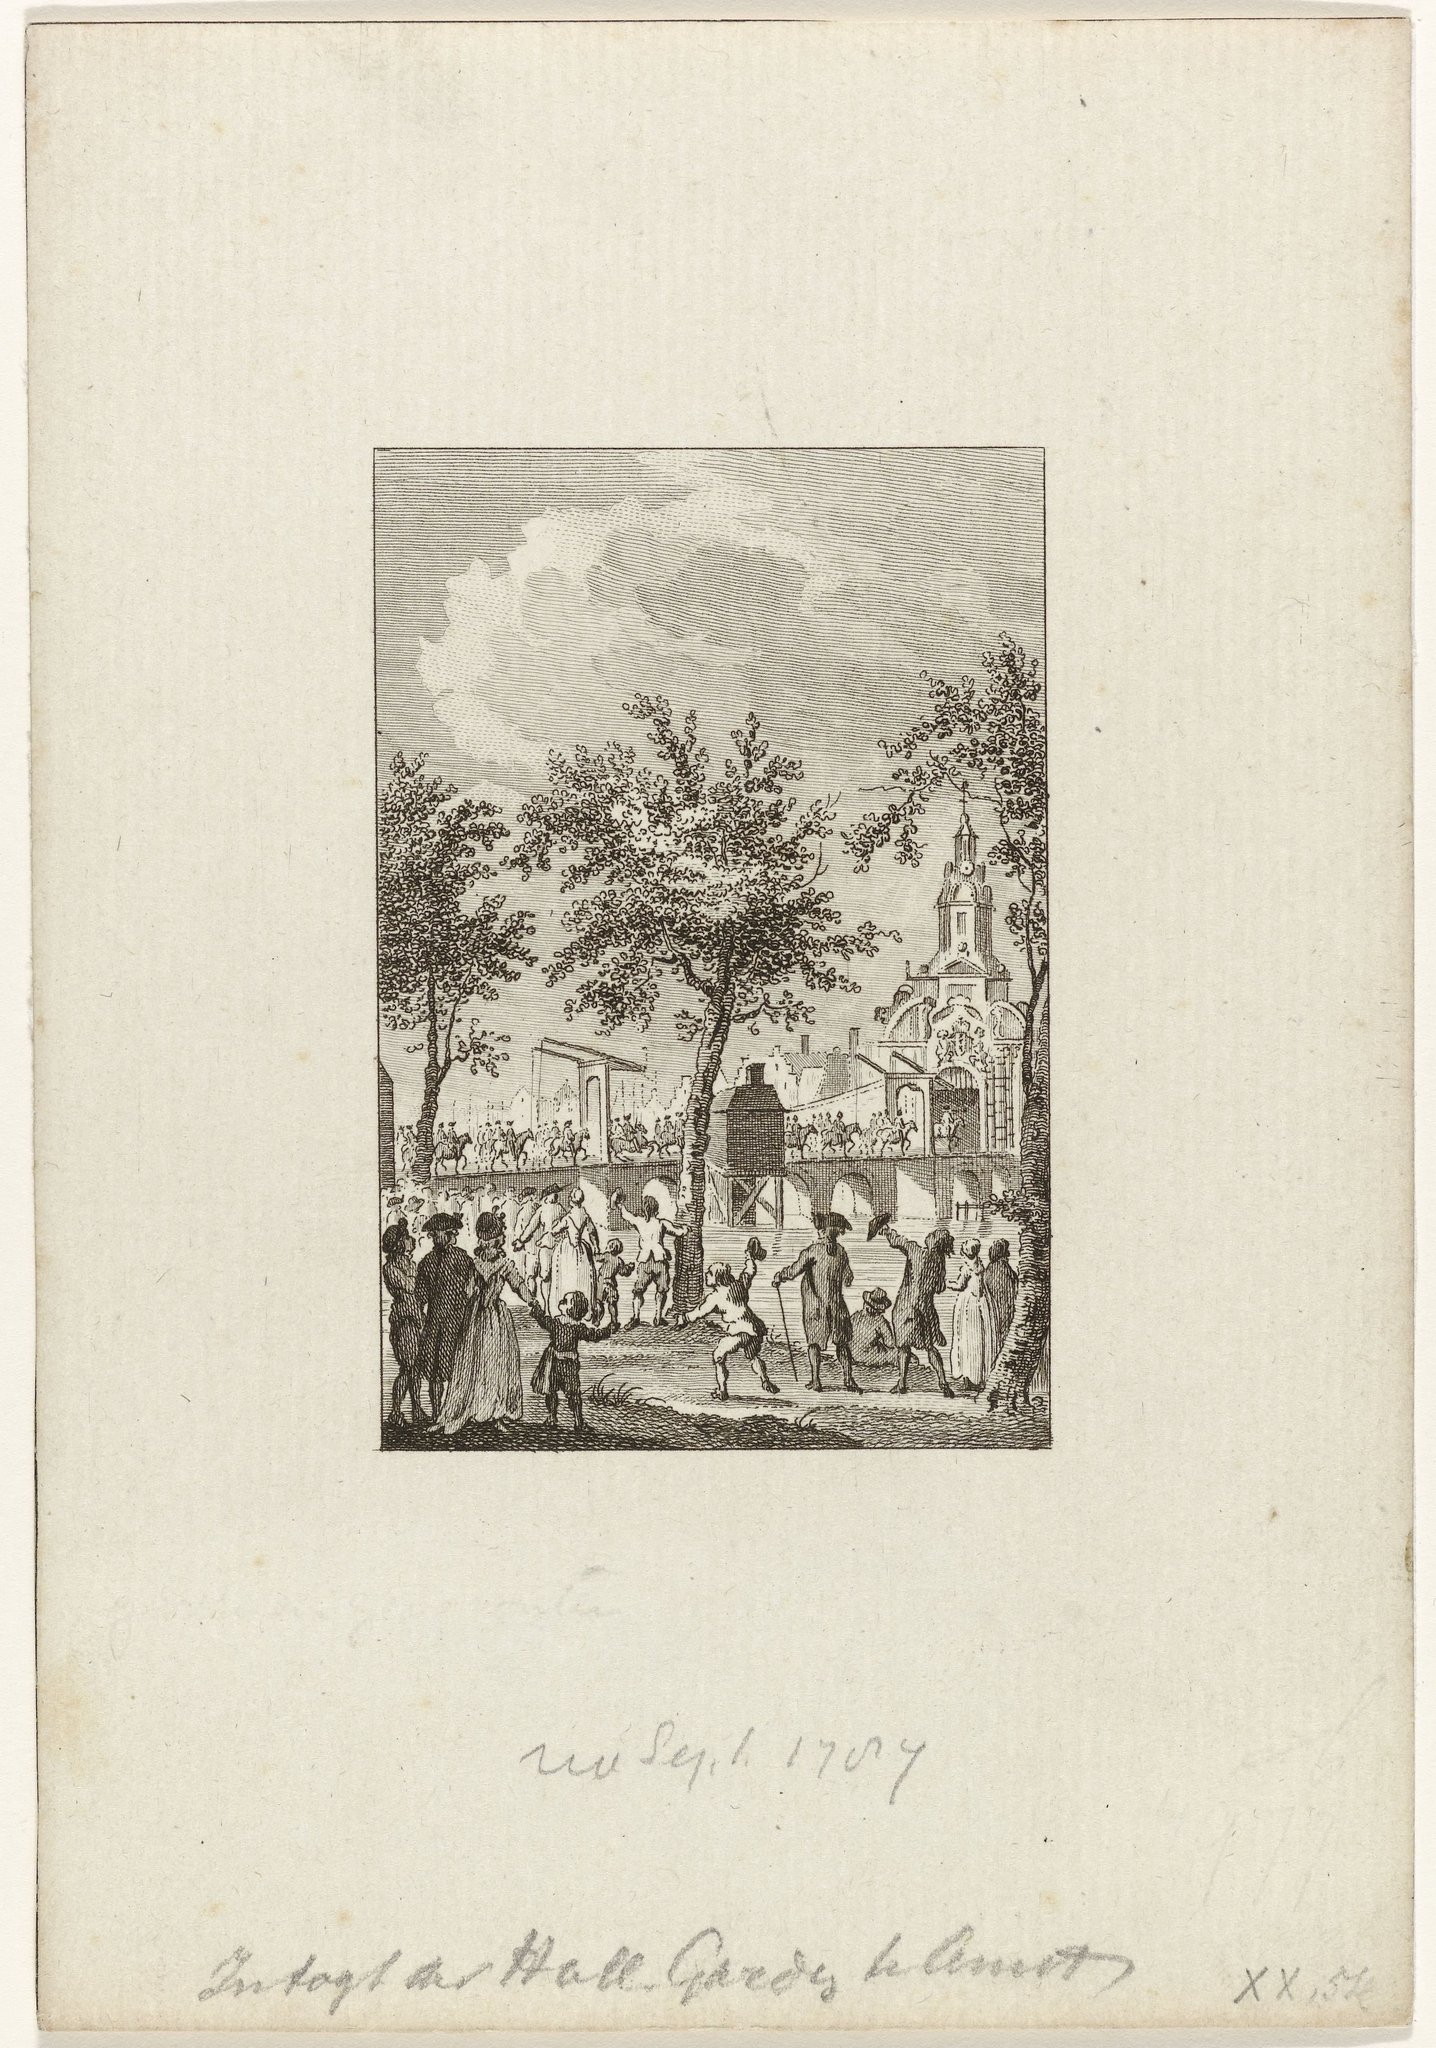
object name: print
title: Intocht van de Hollandse Garde te Amsterdam, 1787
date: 1787-1795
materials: paper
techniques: etching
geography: northern netherlands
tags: march into the conquered place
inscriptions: collector's mark: Lugt 2228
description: Gebruikt als illustratie in: J. Fokke, Geschiedenissen der Vereenigde Nederlanden voor de vaderlandsche jeugd, Johannes Allart, Amsterdam 1783-1795, 25 delen, dl. 20, pl. 5.